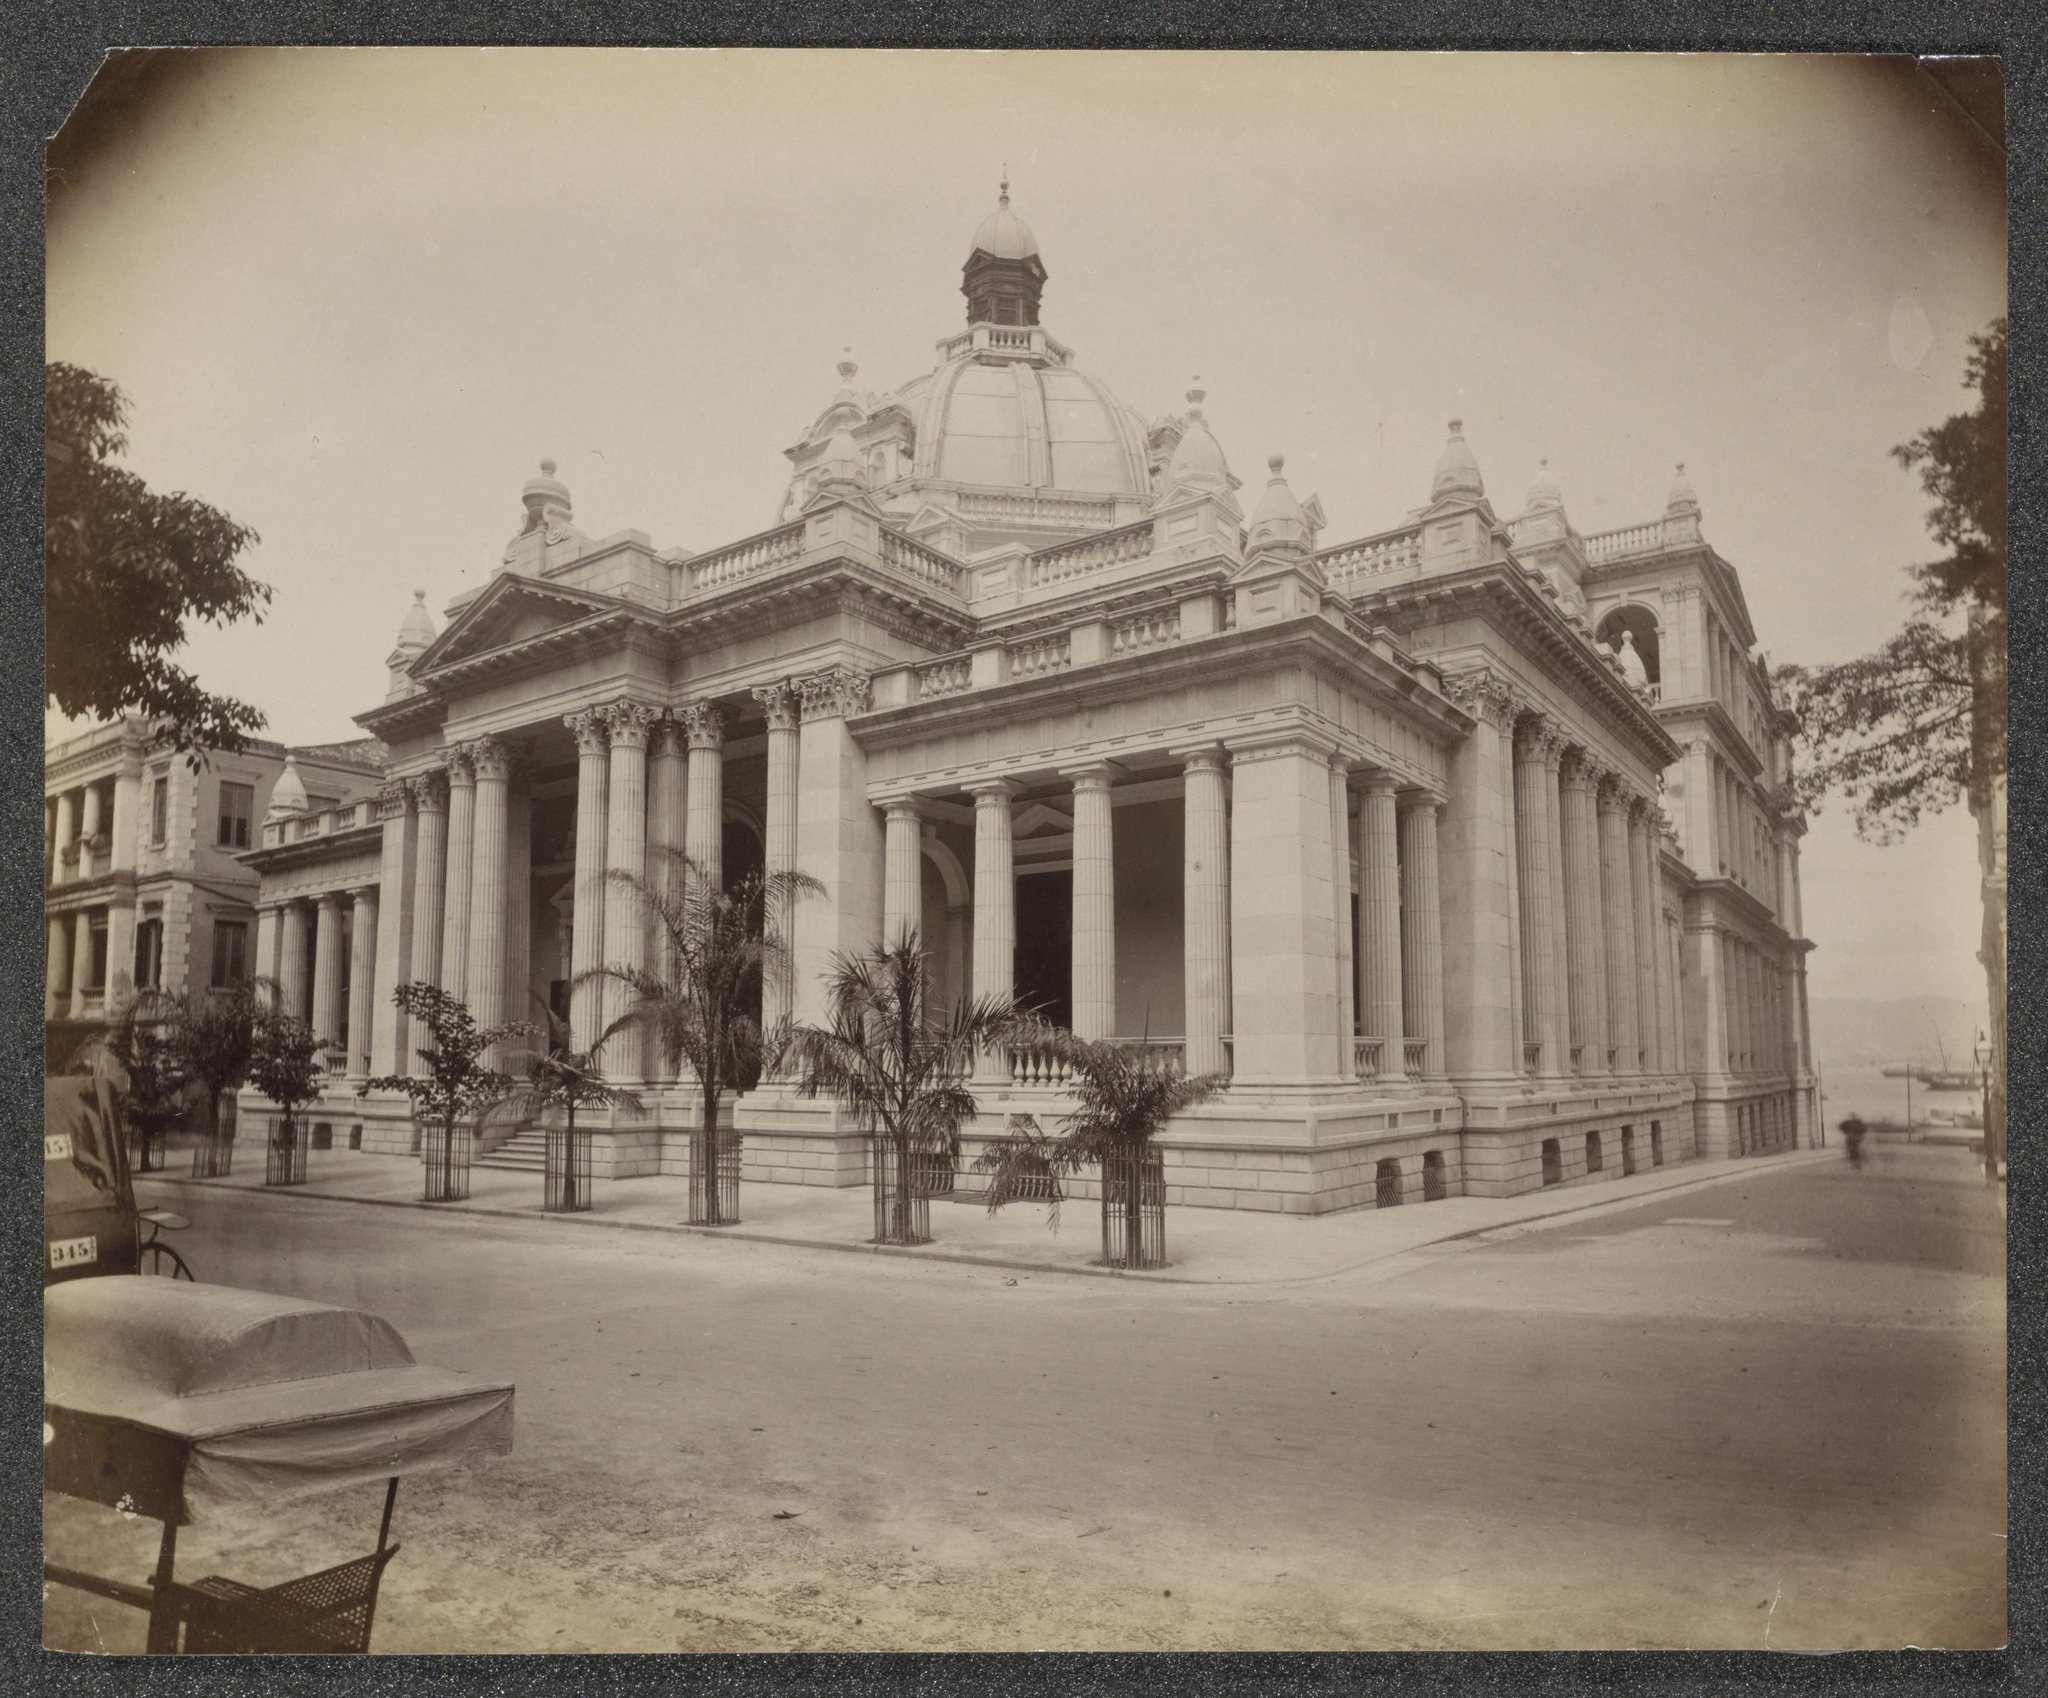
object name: photograph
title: Exterieur van de Hong Kong-Shanghai Bank in Hong Kong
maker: Anonymous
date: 1860-1900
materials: paper, photographic support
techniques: albumen print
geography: hong kong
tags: exterior ~ representation of a building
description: Onderdeel van Album met 50 foto's van een reis door Zuidoost-Azië.